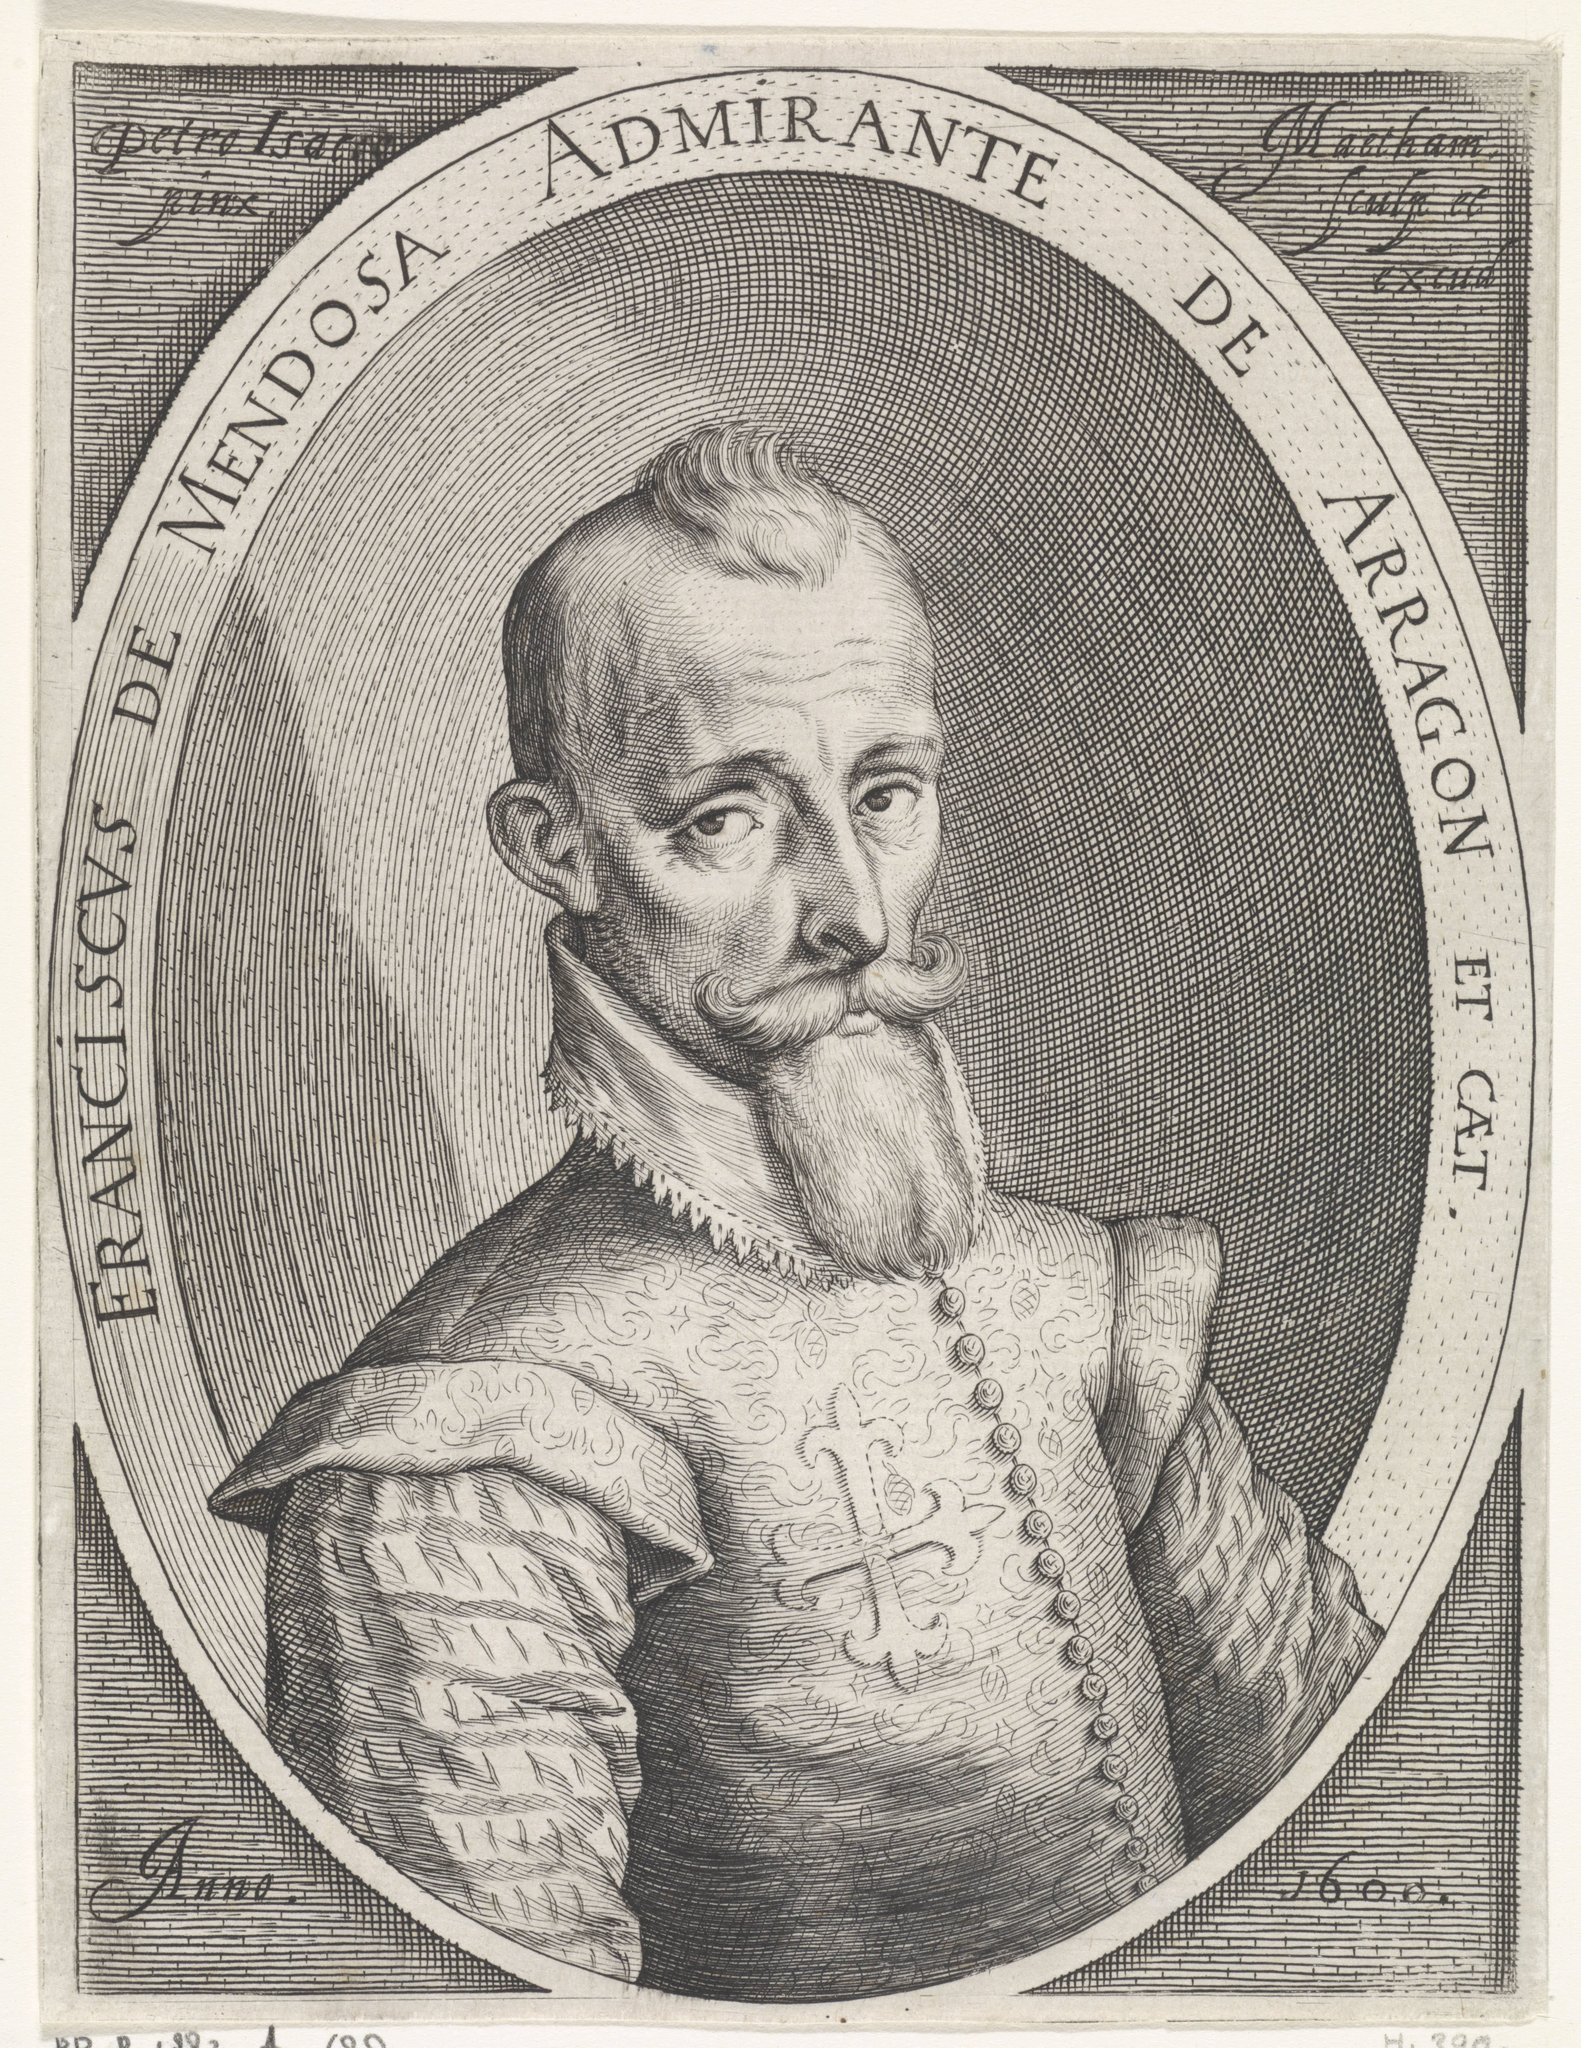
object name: print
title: Portret Francisco Hurtado de Mendoza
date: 1600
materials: paper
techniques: engraving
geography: haarlem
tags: historical persons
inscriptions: collector's mark: Lugt 2228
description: Portret van Francisco Hurtado de Mendoza (1545- 1623), admiraal van Aragon, Spaans veldheer in de 80-jarige oorlog. Buste naar rechts, een kruis op de borst, in ovaal met randschrift.